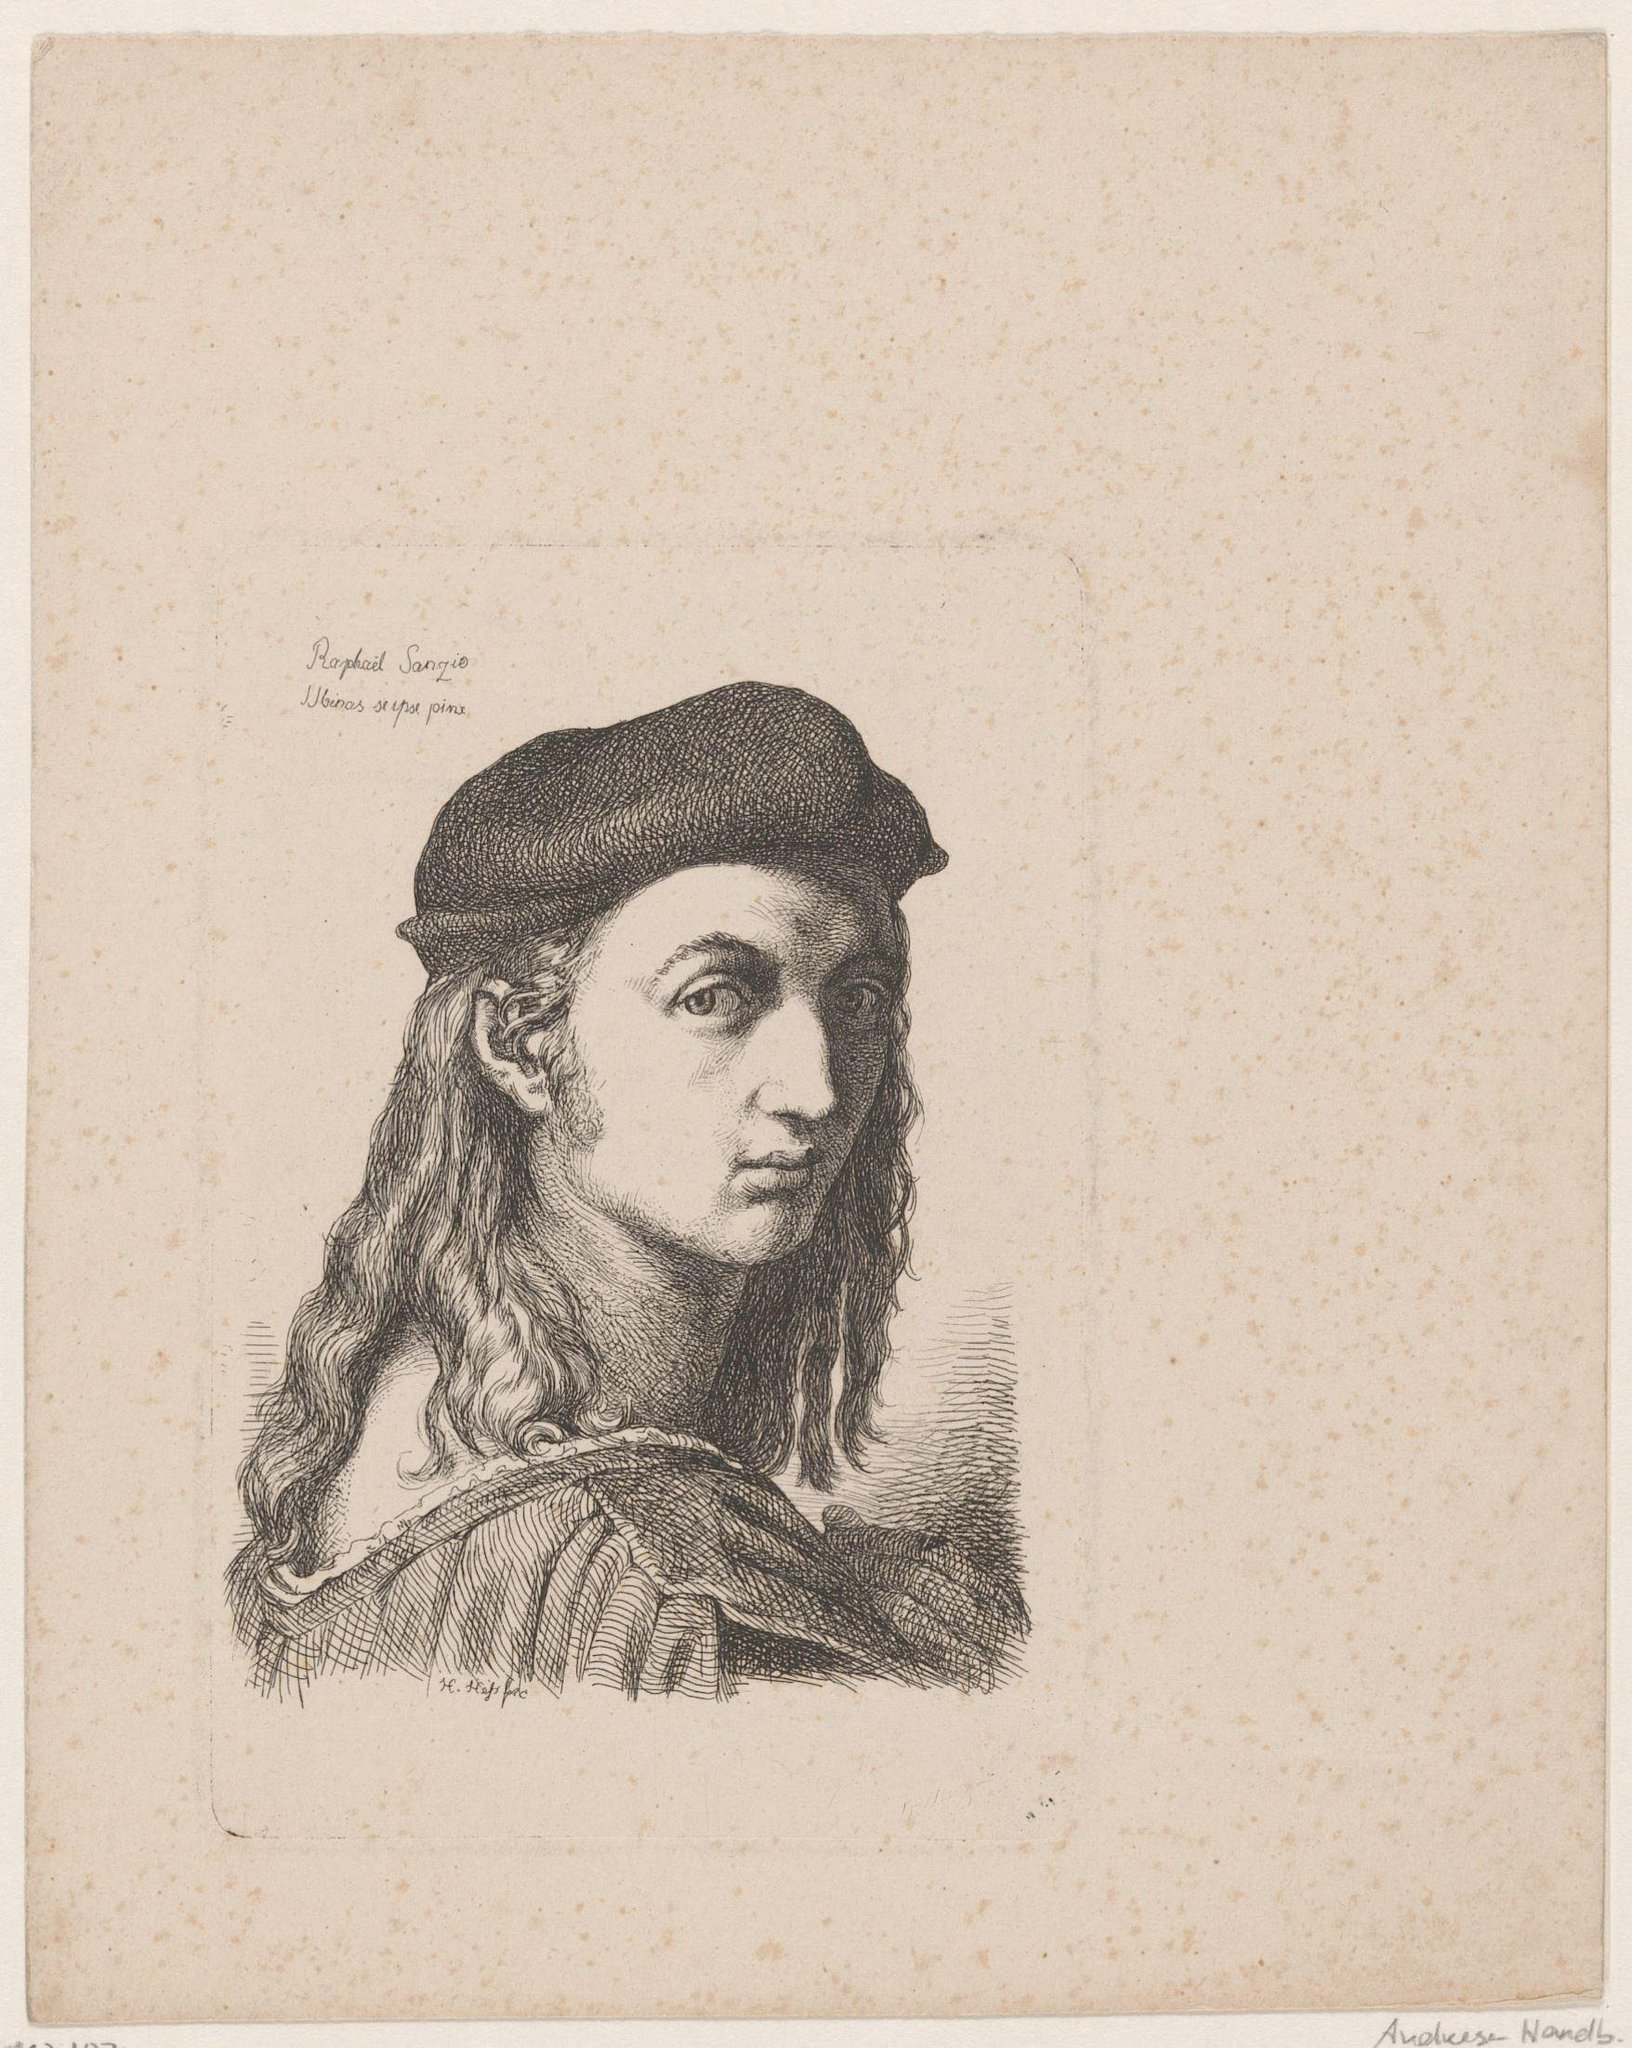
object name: print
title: Portret van Rafaël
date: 1808-1863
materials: paper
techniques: etching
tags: rome, painter, rafaël, historical persons, portrait, self-portrait of artist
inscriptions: collector's mark: Lugt 2228